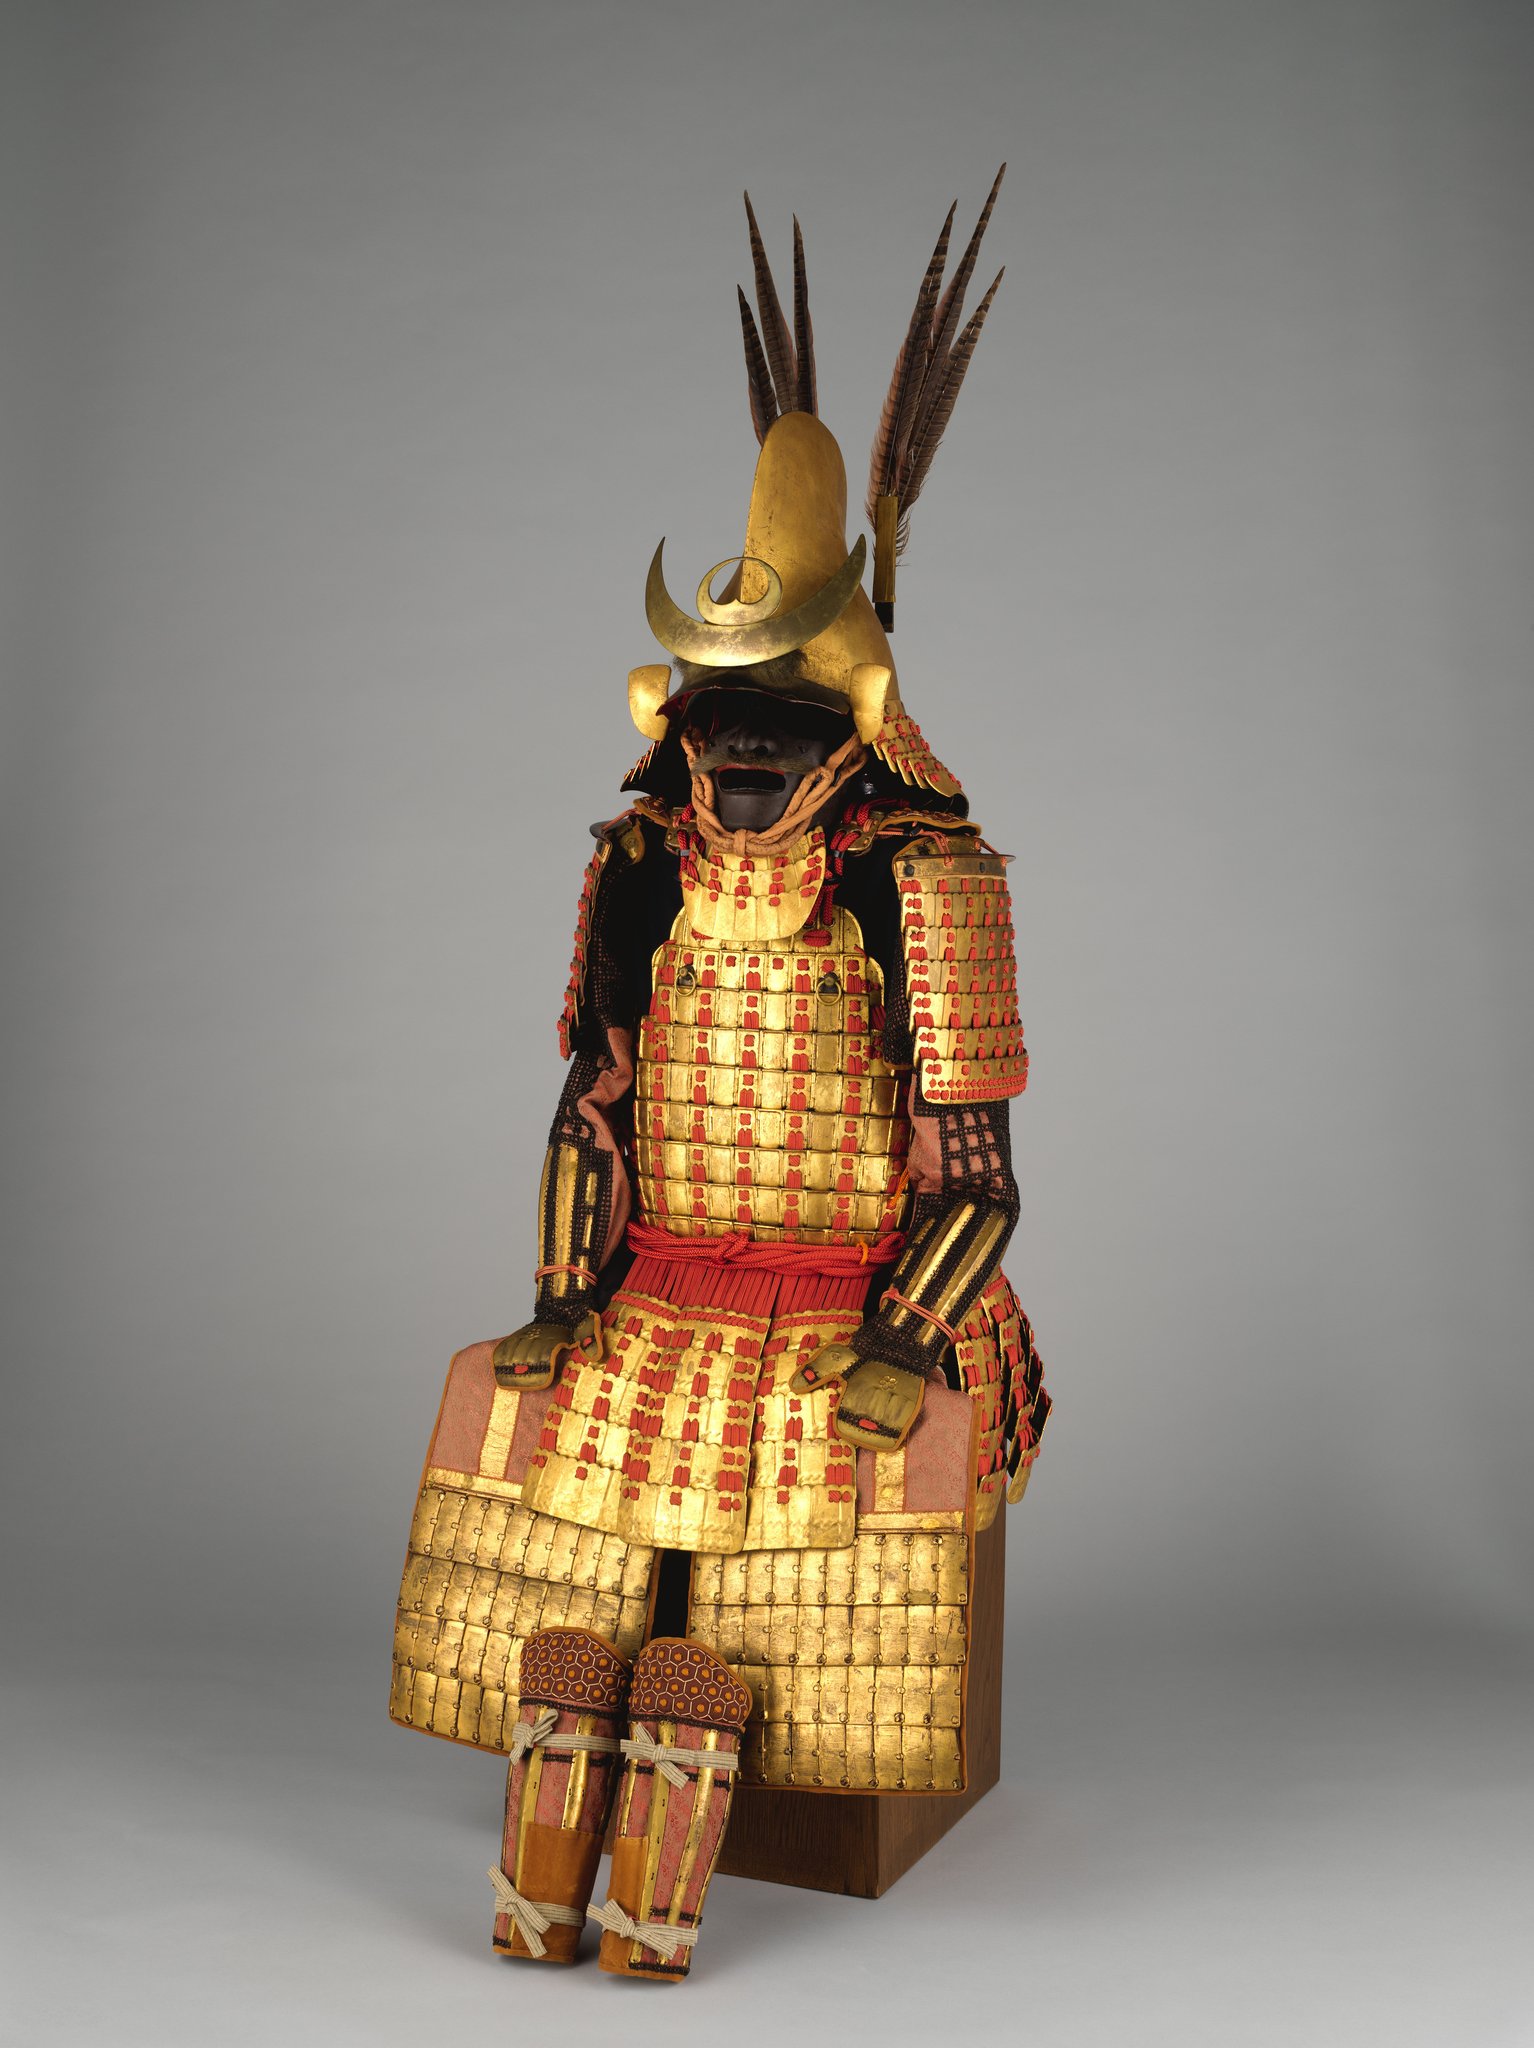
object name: armor i gusoku i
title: Armor (Gusoku)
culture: japanese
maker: hiromichi miura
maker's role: restorer/conservator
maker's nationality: japanese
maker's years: 1938-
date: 1601-1700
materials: copper, gold, iron, lacquer, leather, silk, silver, textile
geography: japan